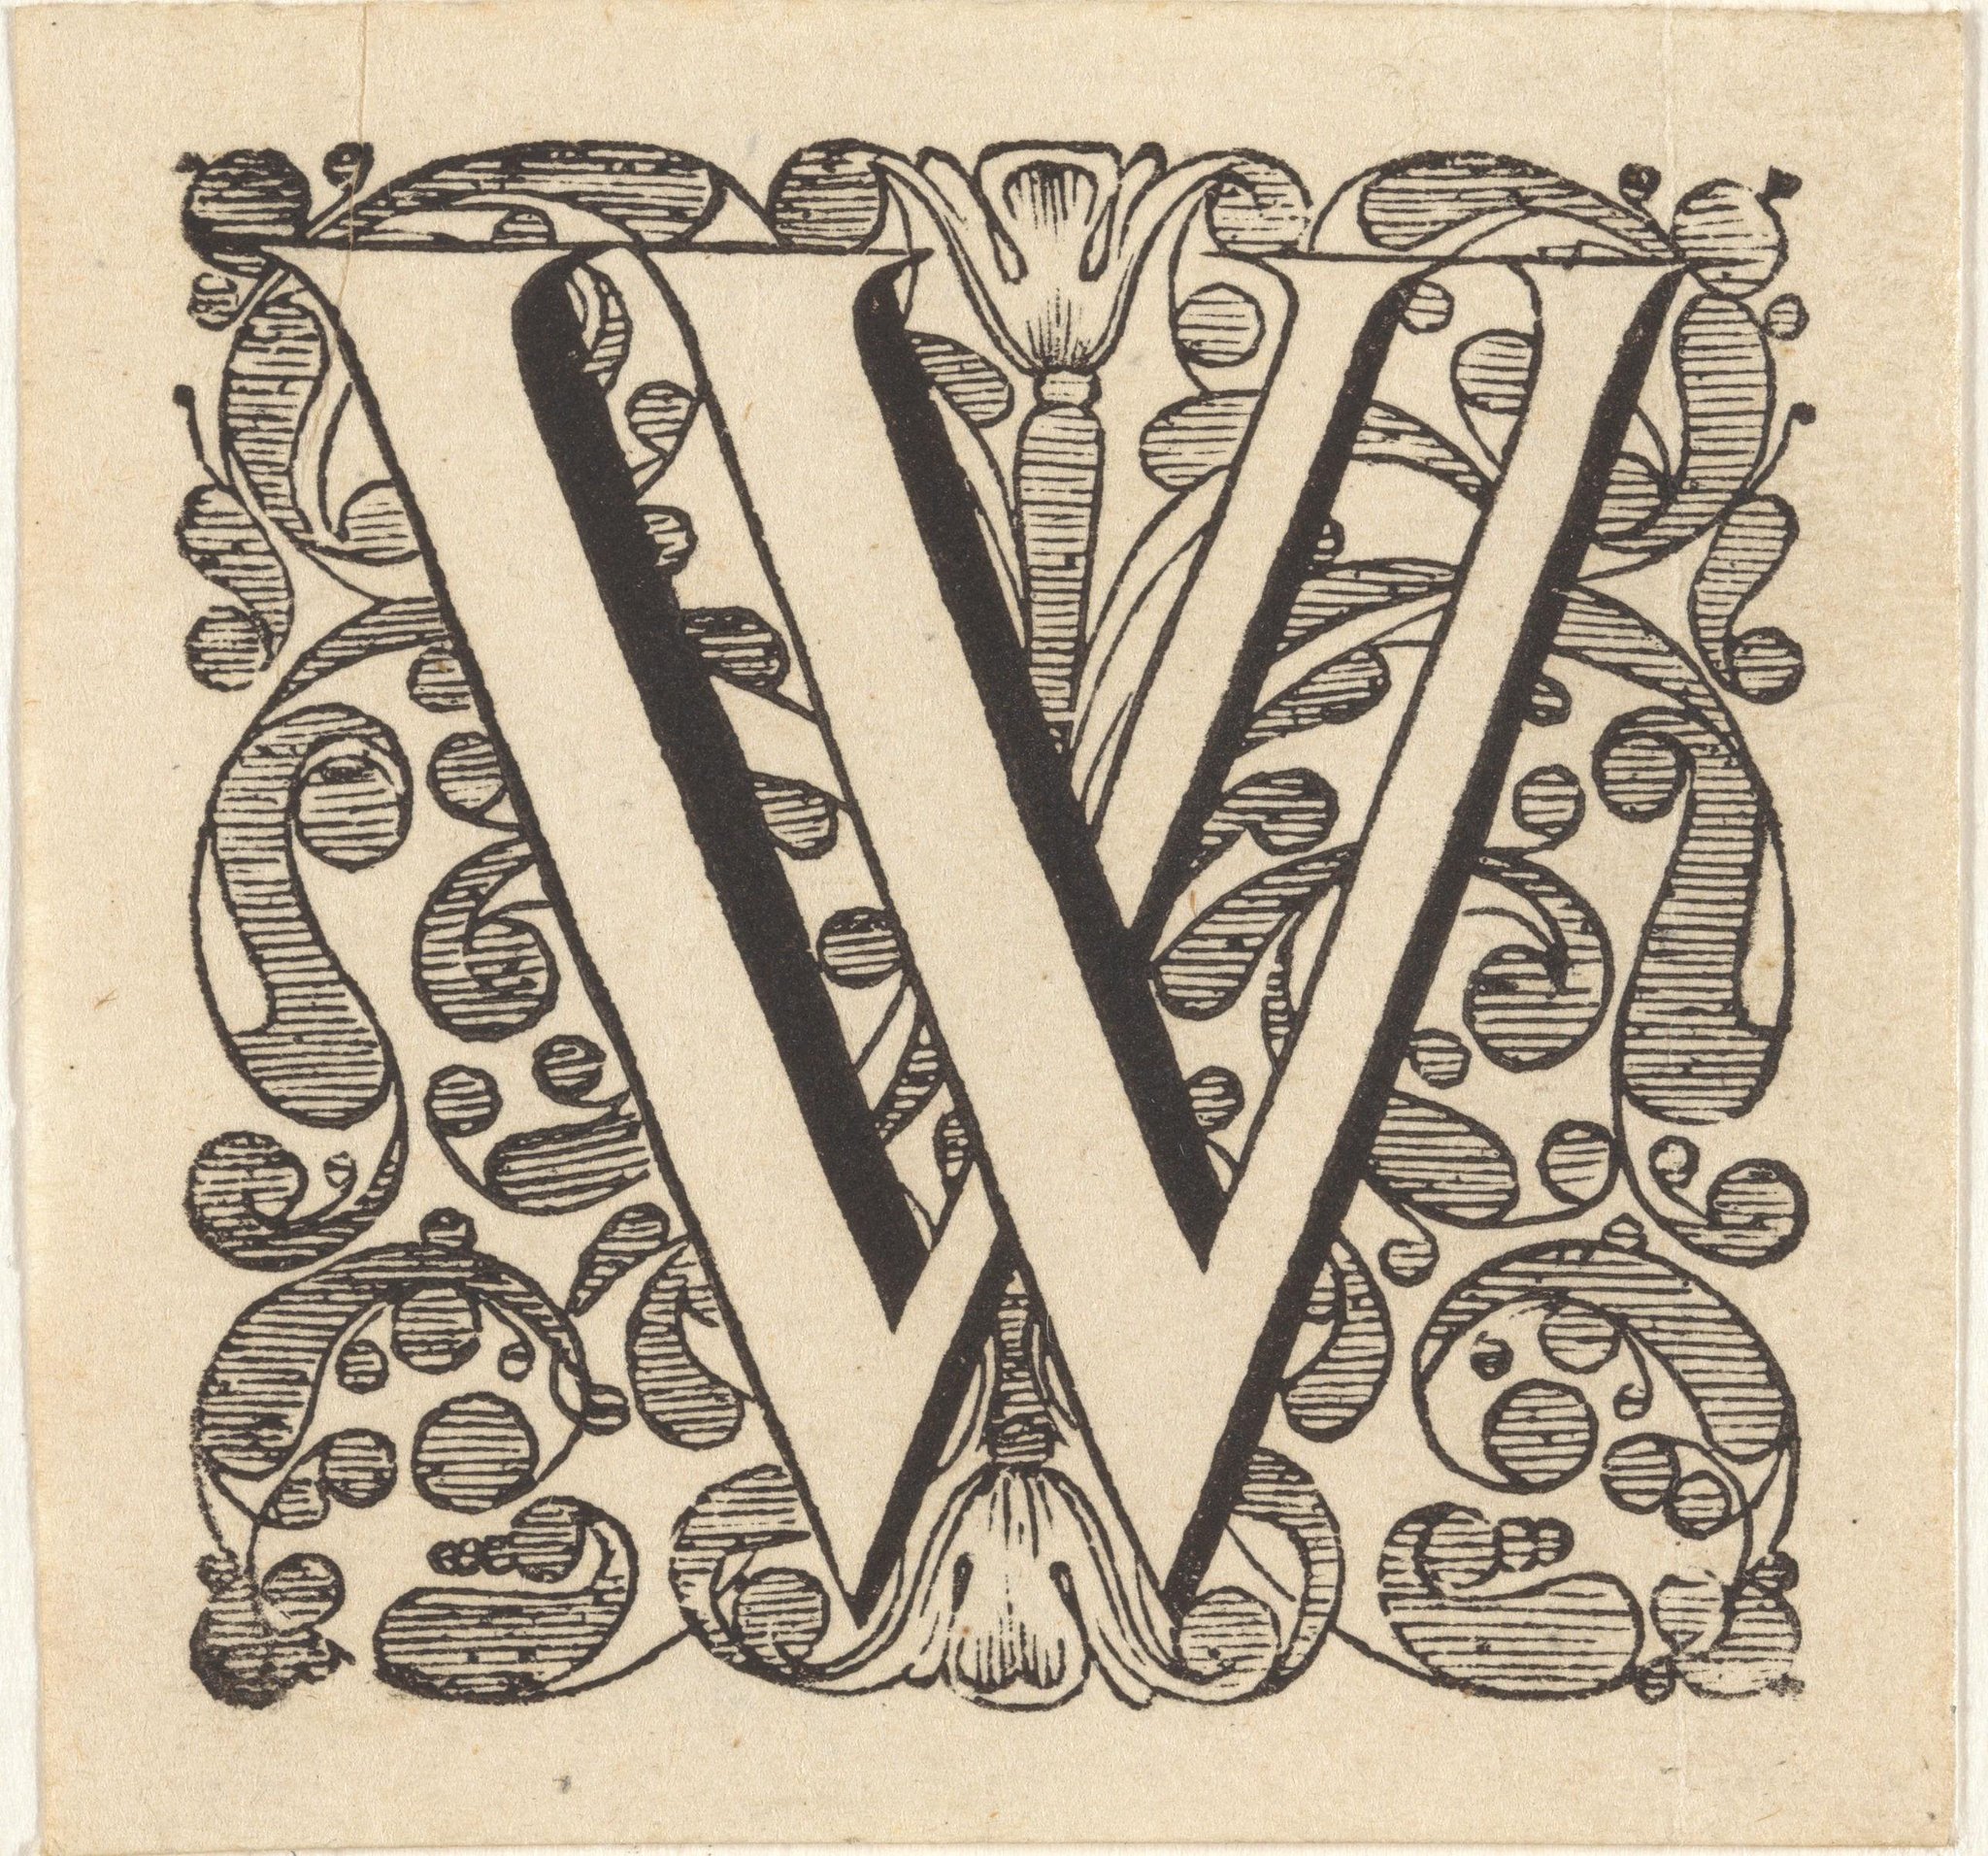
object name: print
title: Letter W in een omlijsting met bloemen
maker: Anonymous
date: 1600-1699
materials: paper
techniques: woodcut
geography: netherlands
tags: flowers, fancy letters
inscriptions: collector's mark: Lugt 240